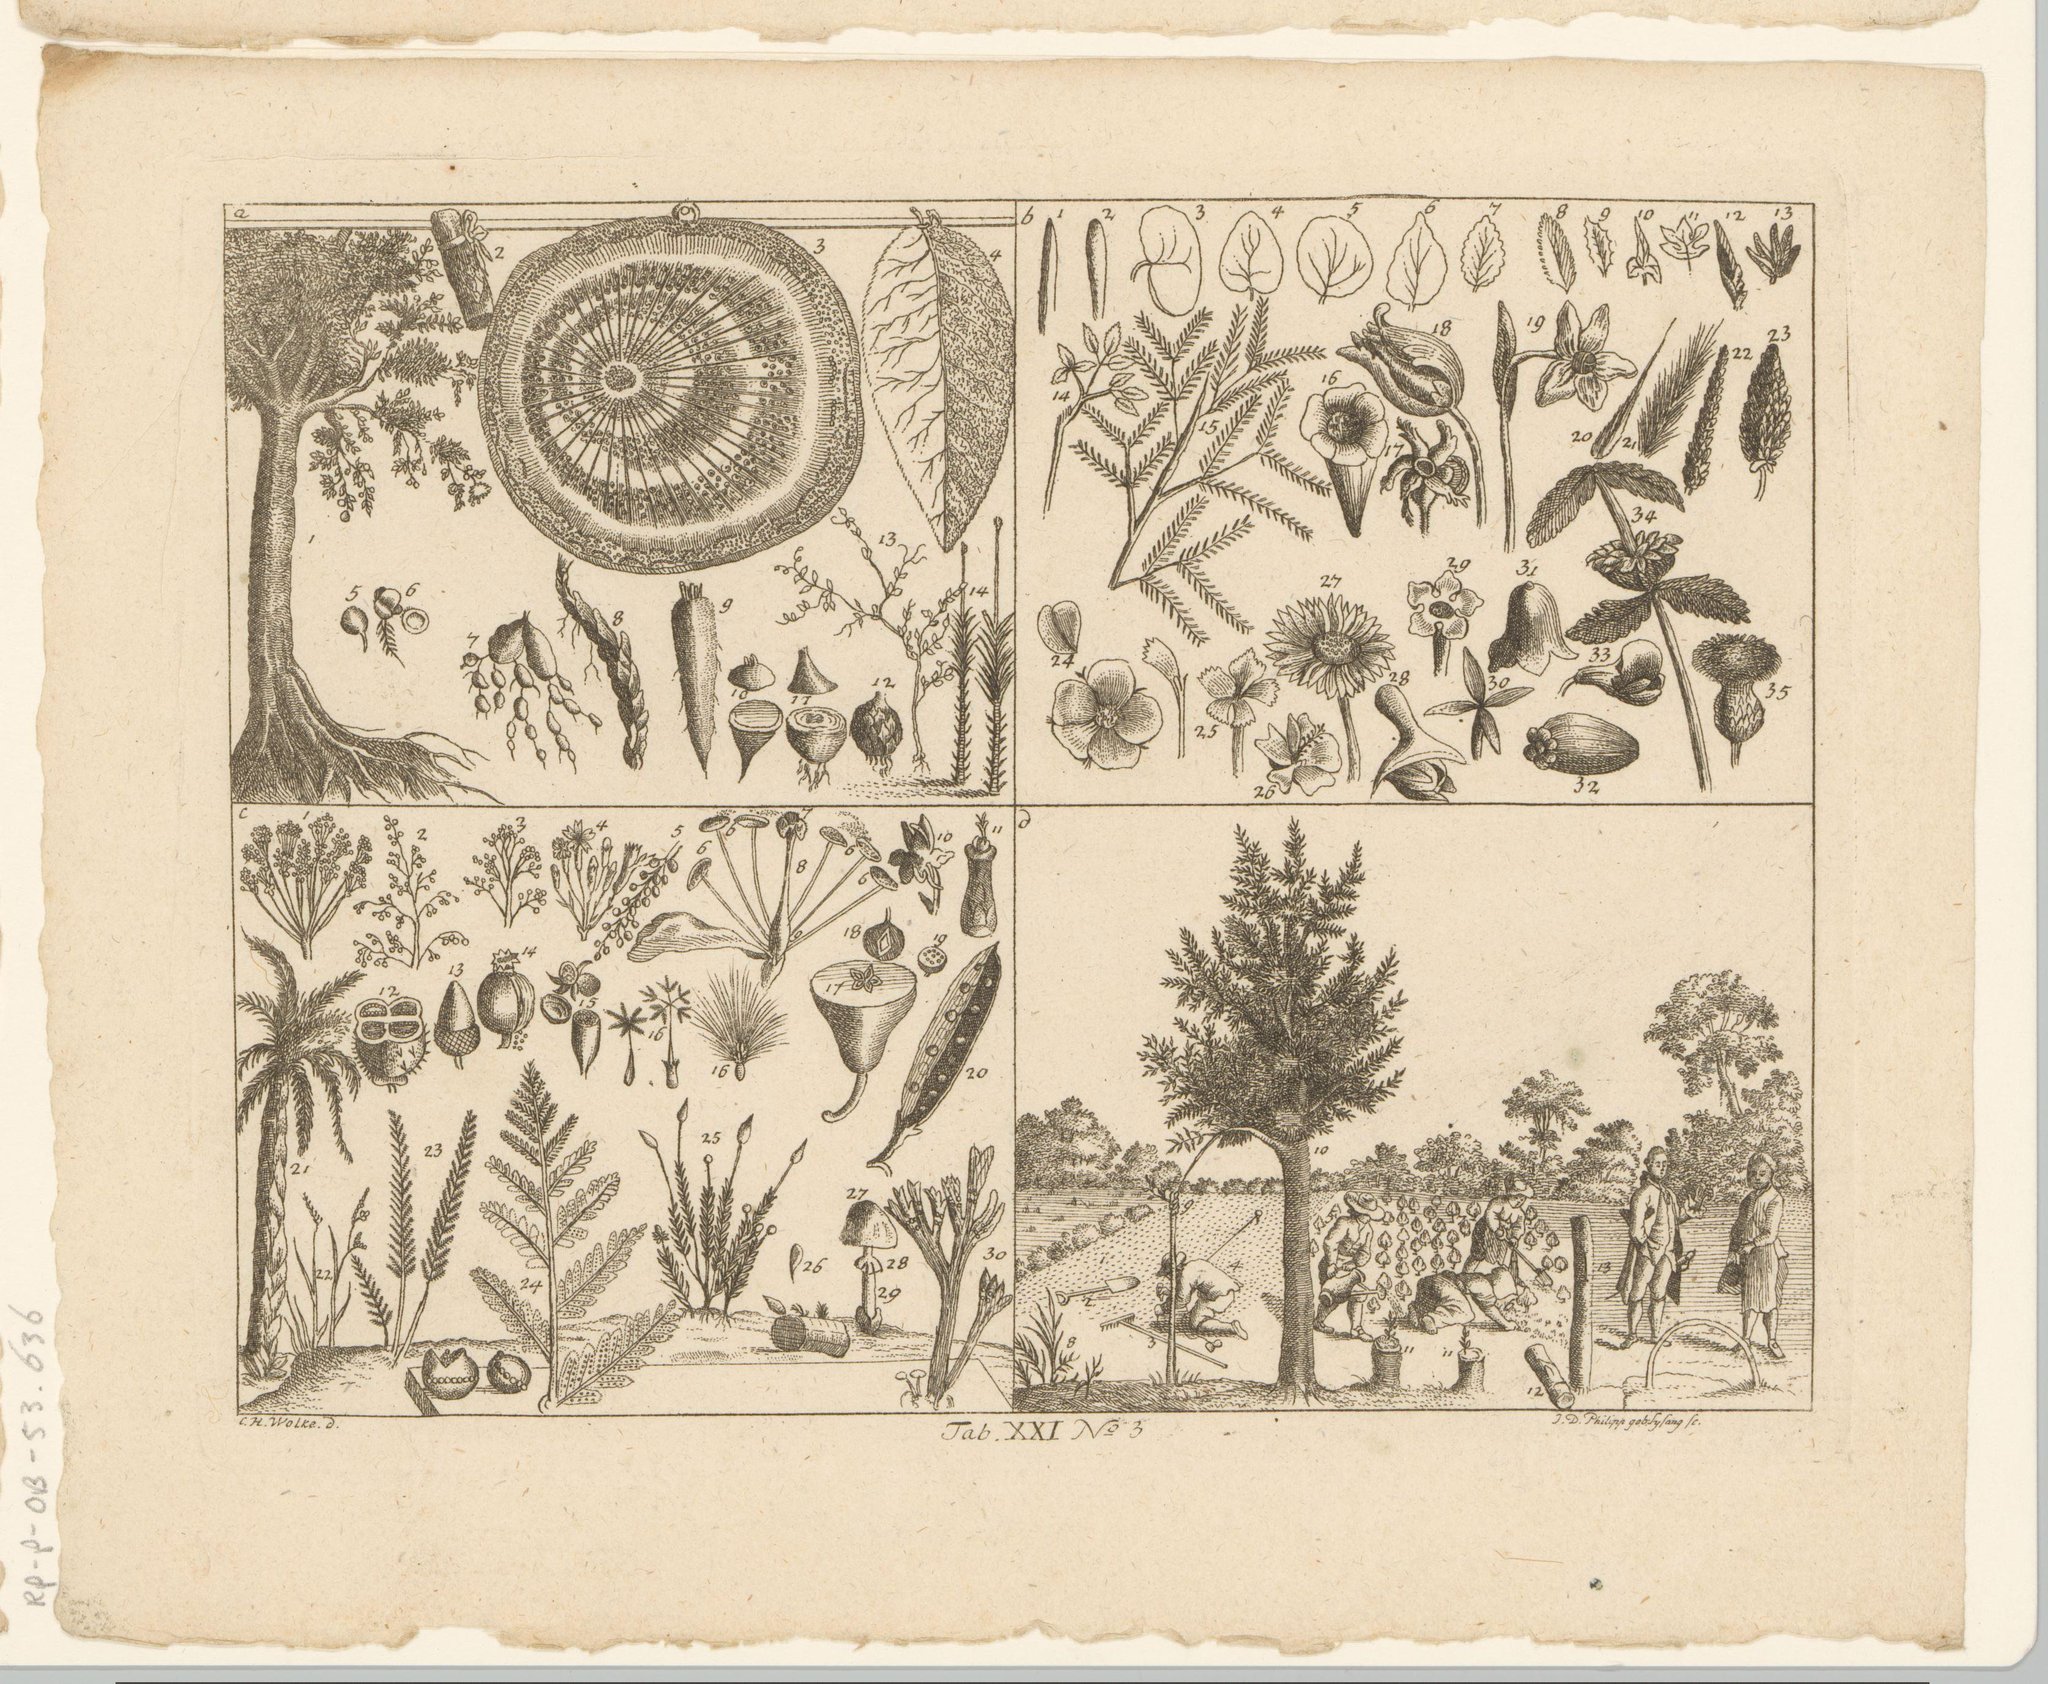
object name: print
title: Encyclopedische voorstelling van planten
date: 1774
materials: paper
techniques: etching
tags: horticulture, vegetable culture, market gardening, plants; vegetation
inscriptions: collector's mark: Lugt 2228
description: Prent afkomstig uit: Kupfersammlung zu J. B. Basedows Elementarwerke für die Jugend und ihre Freunde. Berlijn: Daniel Chodowiecki, 1774.